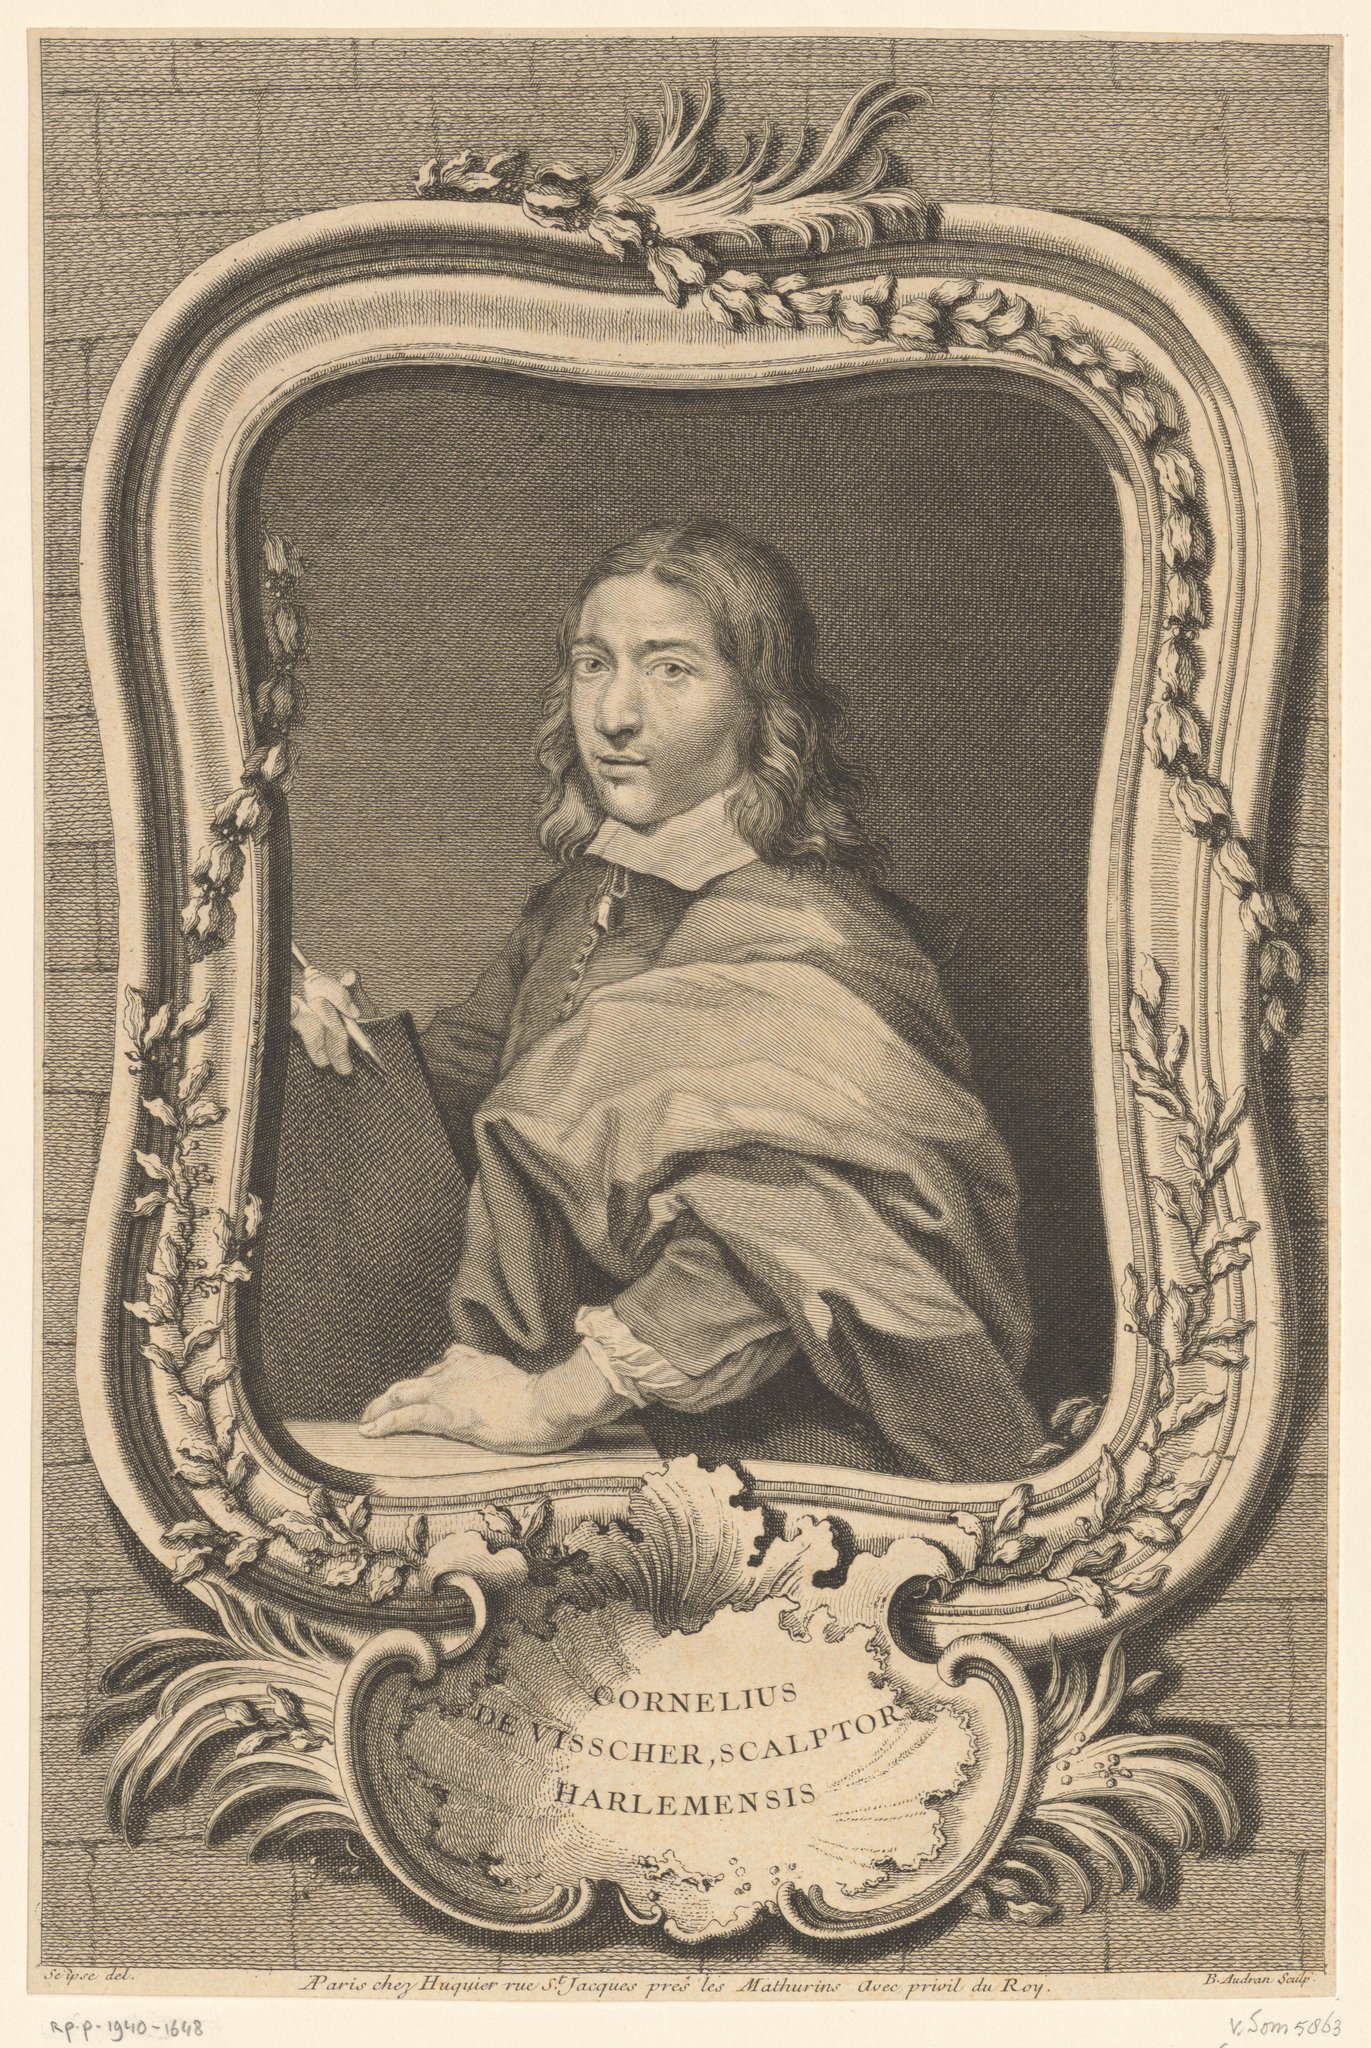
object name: print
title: Cornelius De Visscher, scalptor Harlemensis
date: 1708-1772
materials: paper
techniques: engraving, etching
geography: paris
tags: haarlem, painter, print maker, draughtsman, cornelis visscher (ii), historical persons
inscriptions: collector's mark: Lugt 2760, collector's mark: Lugt 2166